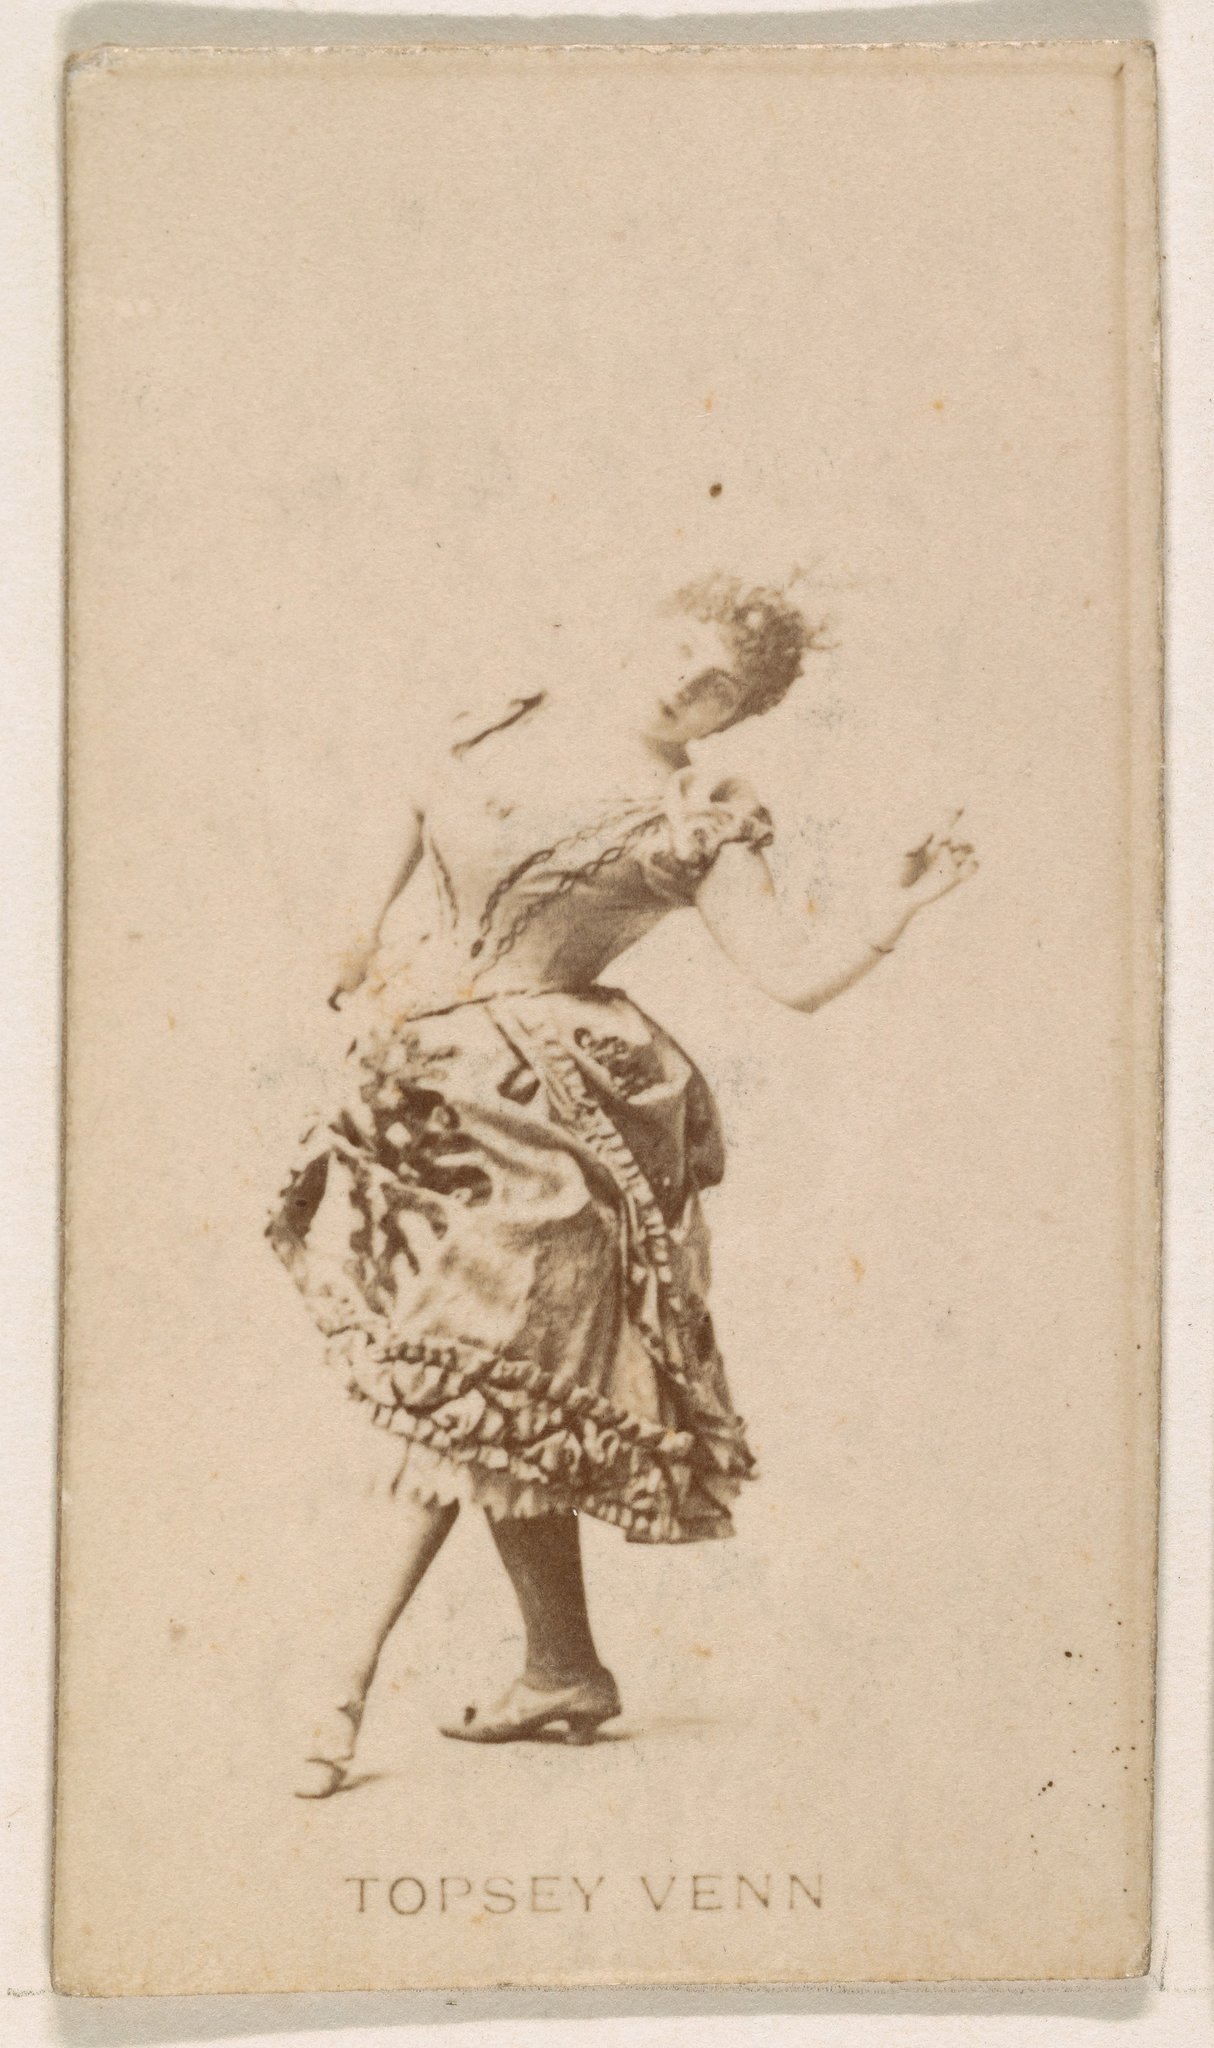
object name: photograph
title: Topsey Venn, from the Actresses series (N245) issued by Kinney Brothers to promote Sweet Caporal Cigarettes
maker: kinney brothers tobacco company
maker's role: publisher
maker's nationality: american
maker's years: 1869-2011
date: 1890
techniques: albumen silver print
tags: portraits,women,actresses